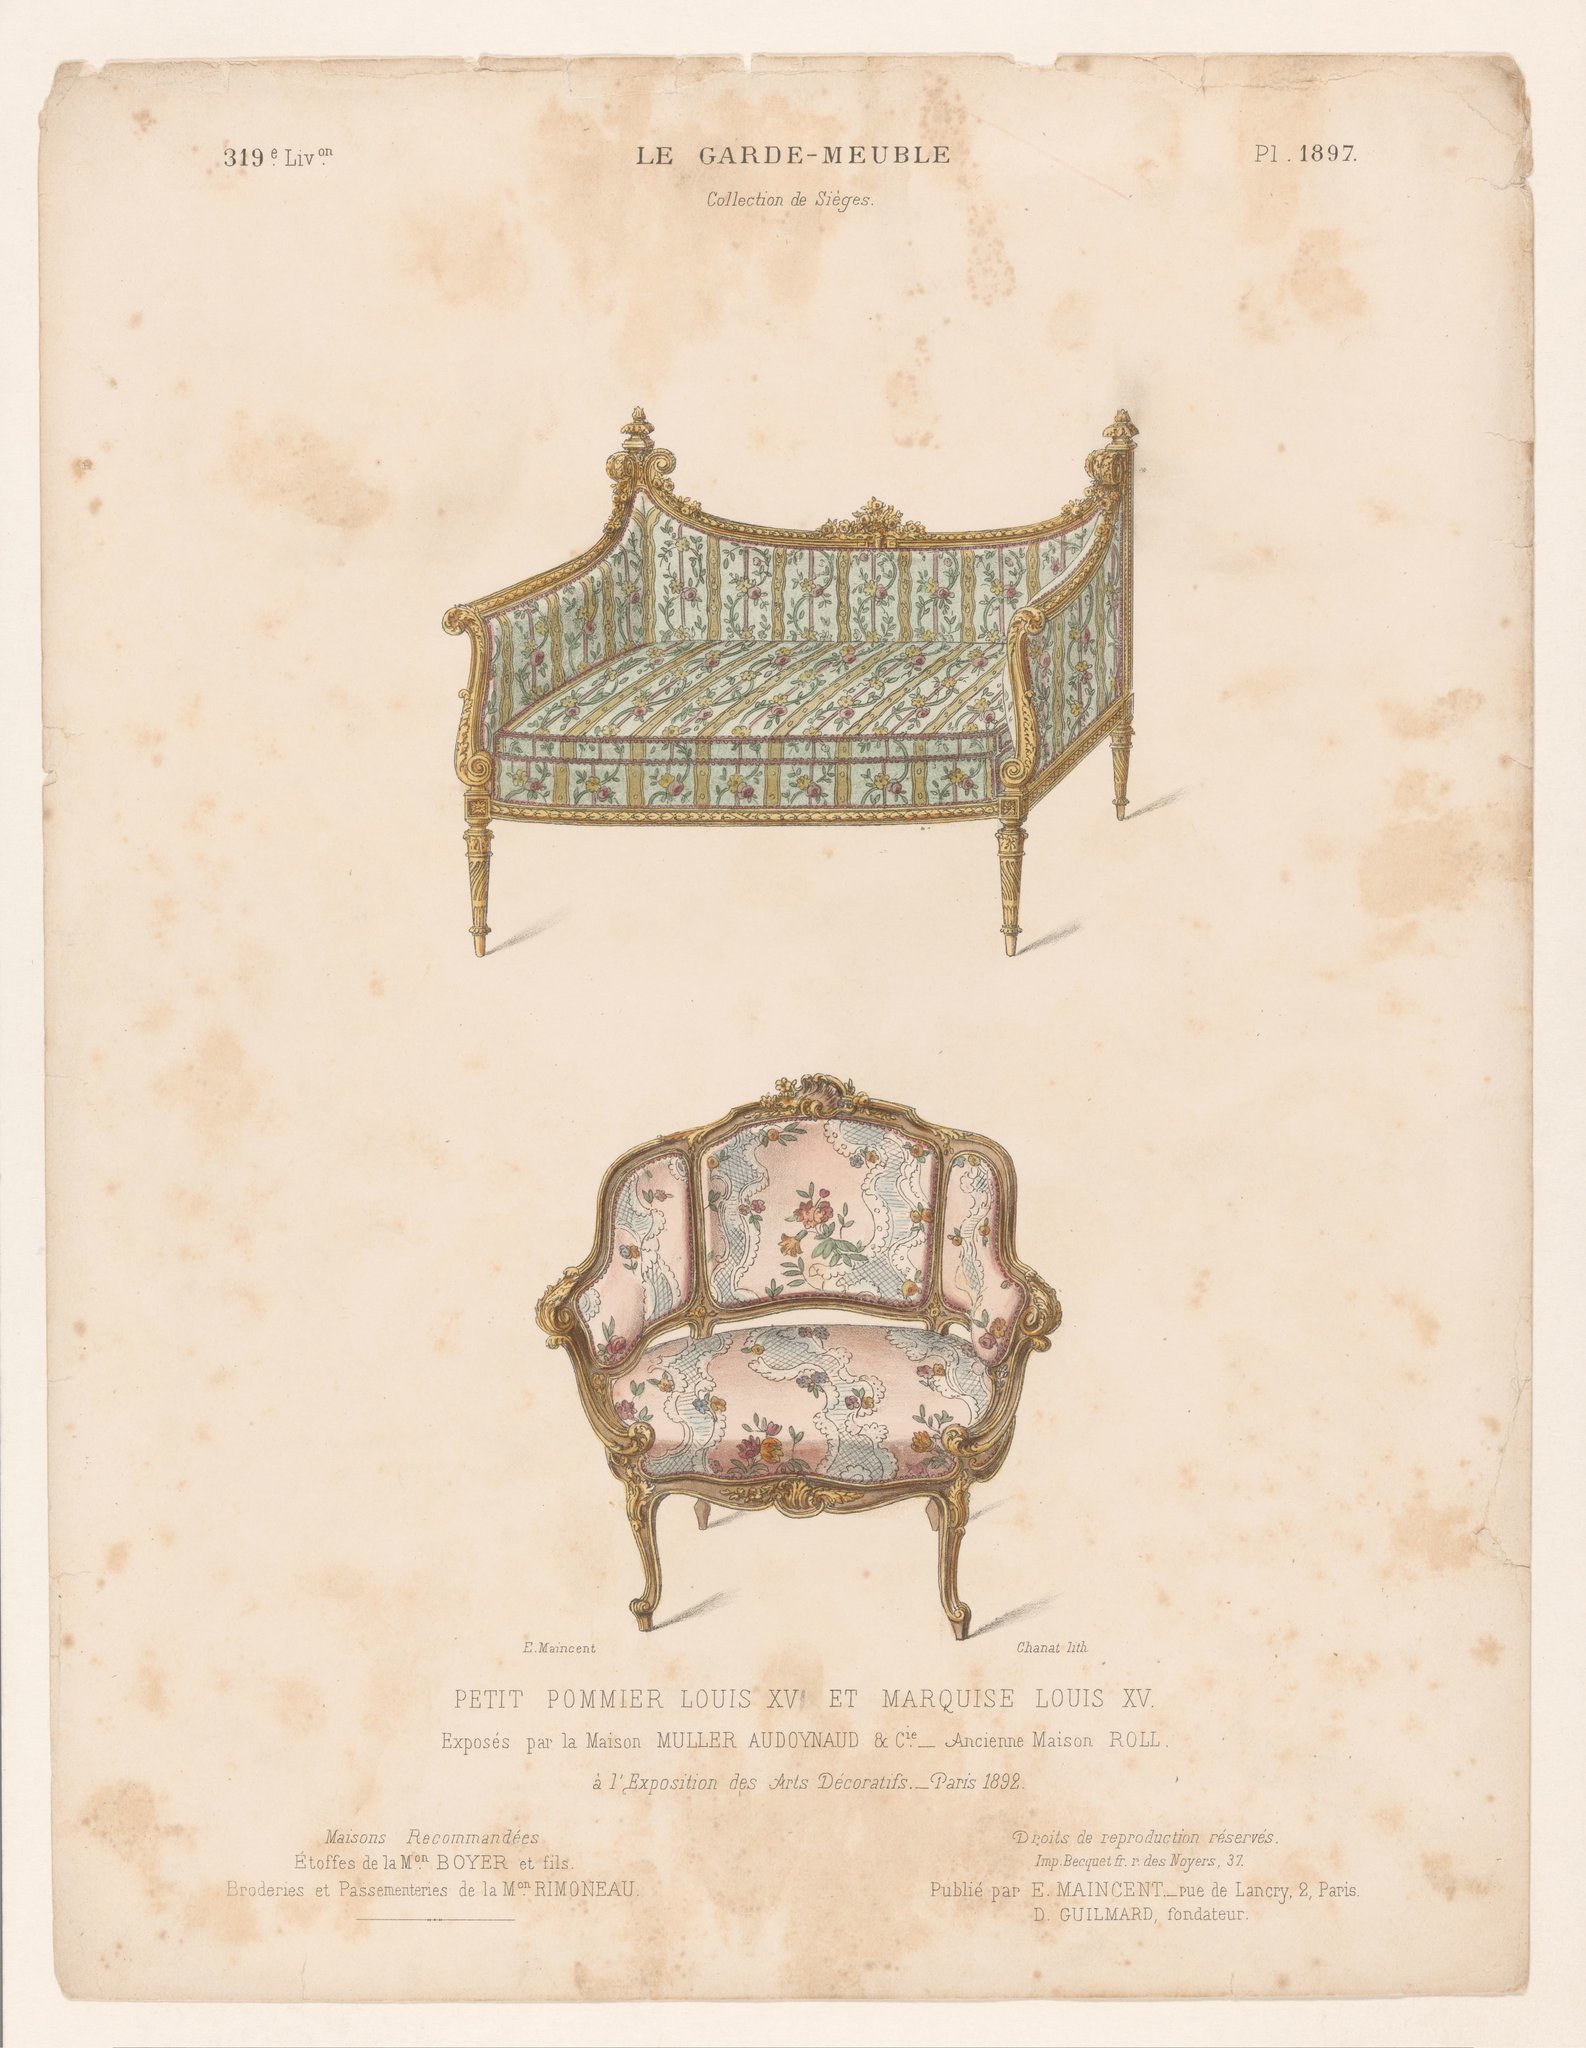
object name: print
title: Le garde-meuble / Collection de Sièges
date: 1885-1895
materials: paper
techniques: hand coloring, lithograph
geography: paris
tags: seating furniture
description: Ieder Livraison in de serie Le Garde-Meuble bevat negen platen: drie 'sièges' (zitmeubels), drie 'meubles' (diverse meubels zoals tafels en kasten) en drie 'tentures' (gordijnen en draperieën).